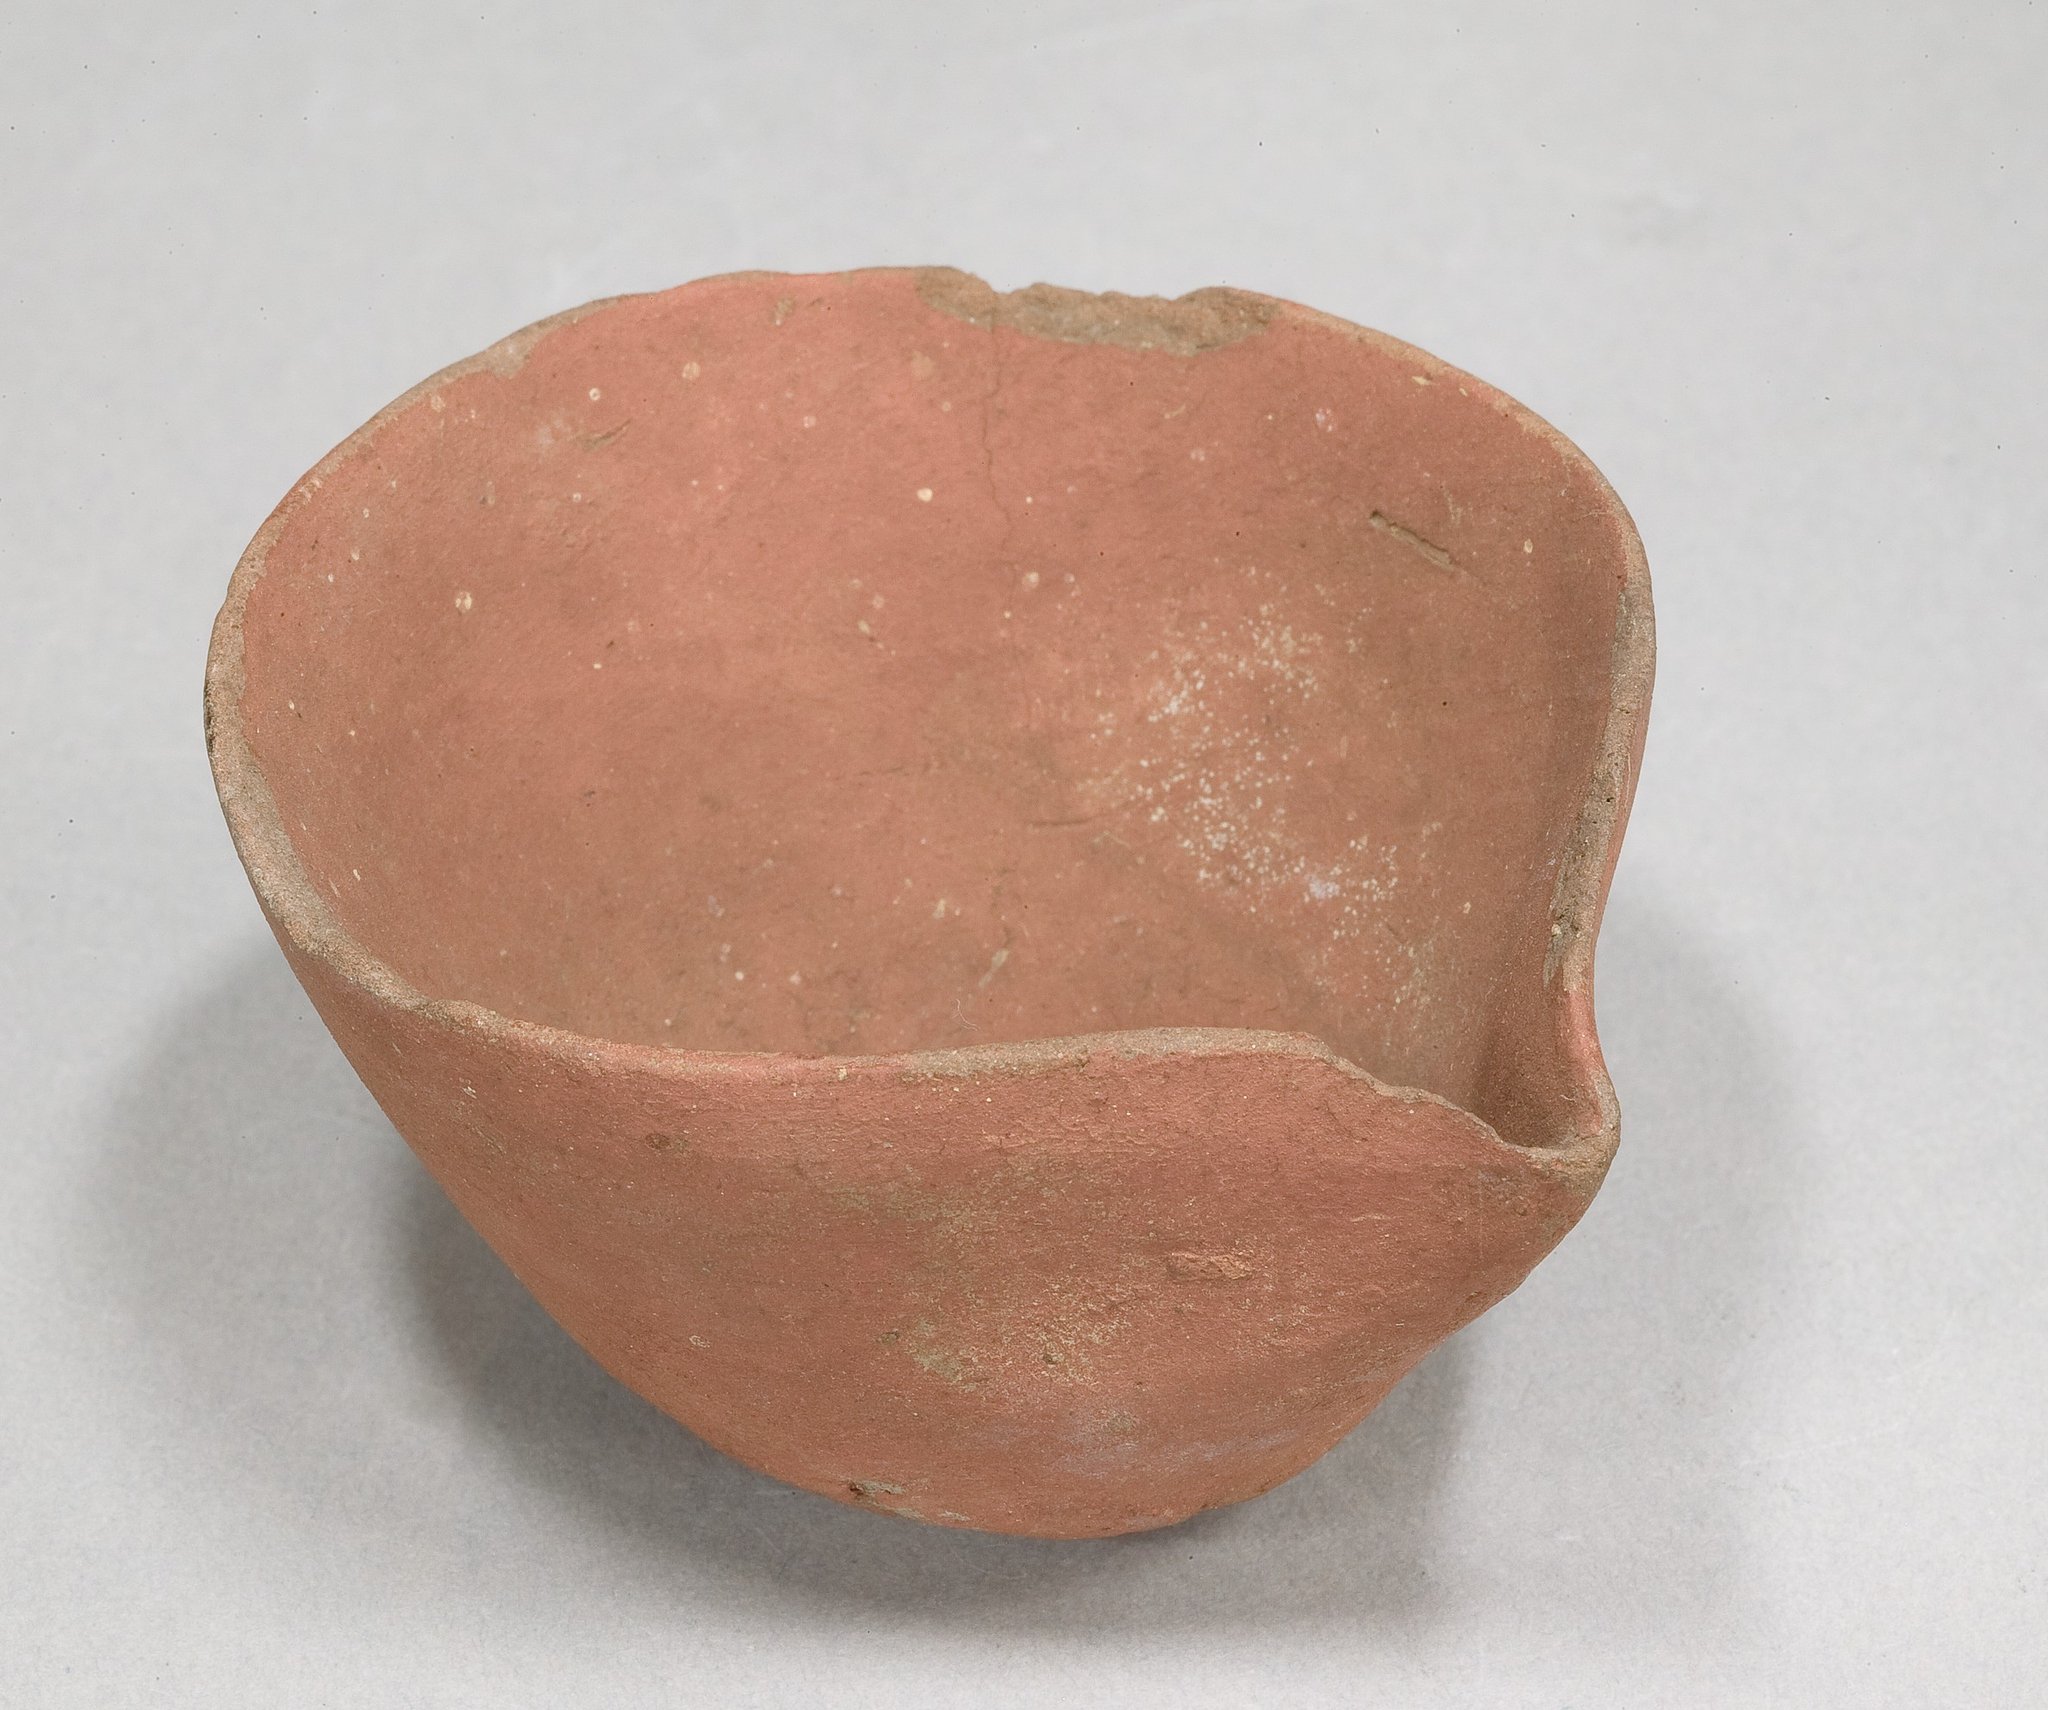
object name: cup, feeding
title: Feeding cup for infant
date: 1950-1850 BCE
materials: pottery